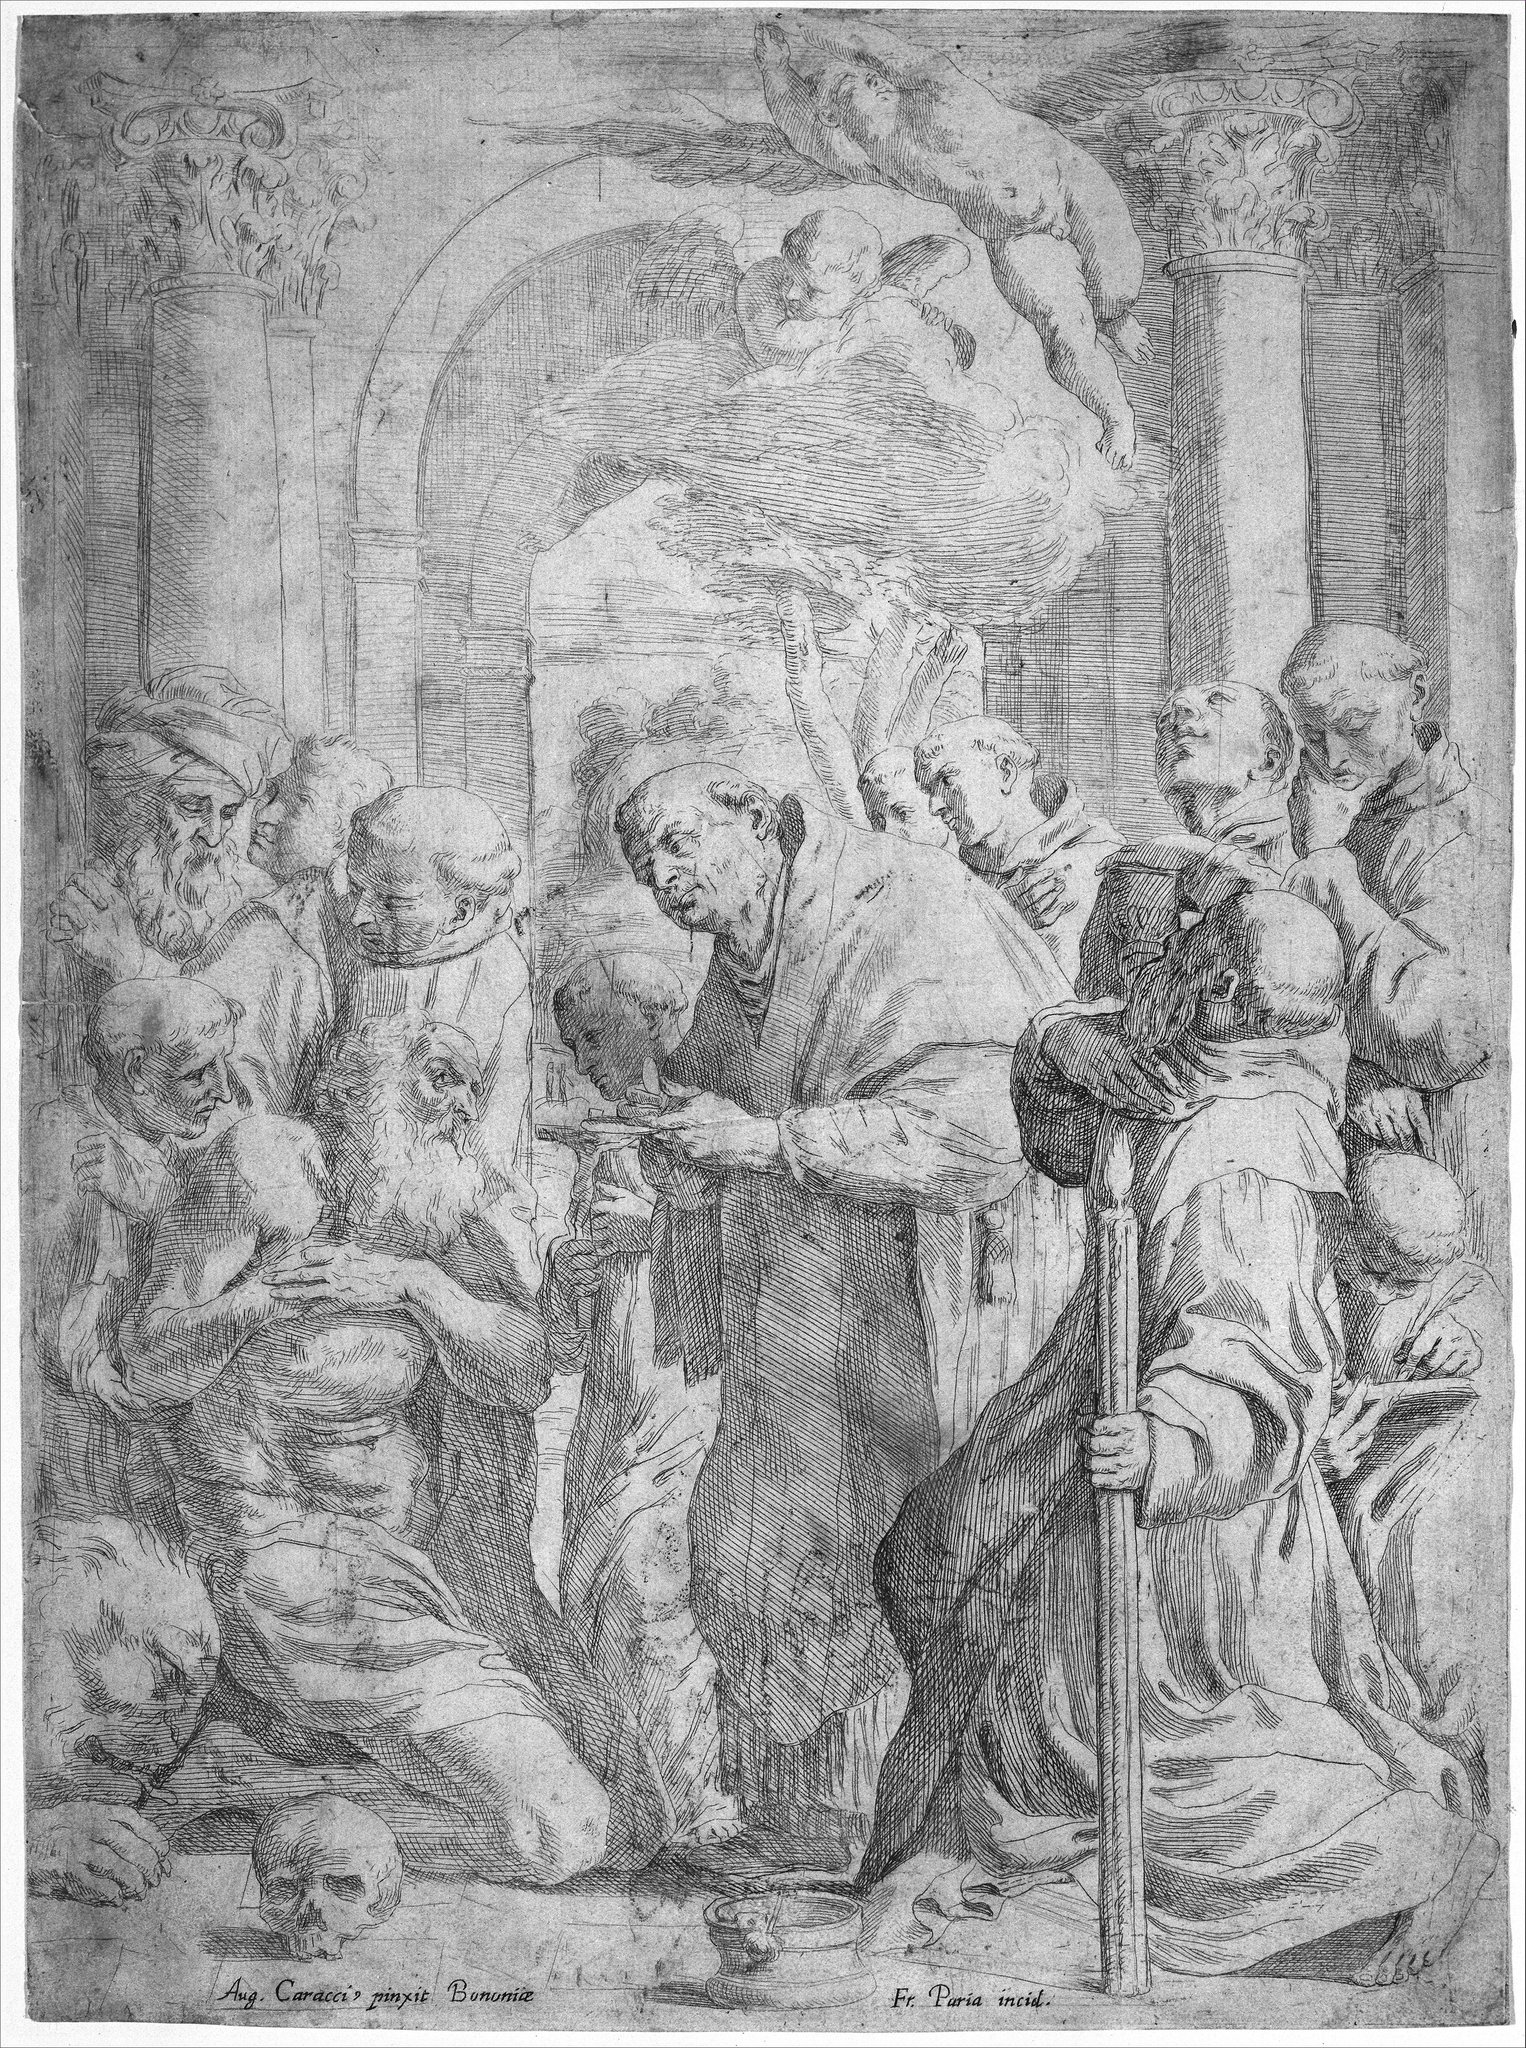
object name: print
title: The Last Communion of Saint Jerome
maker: françois perrier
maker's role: artist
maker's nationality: french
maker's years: 1584-1650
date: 1584-1650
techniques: etching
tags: human figures,angels,saint jerome